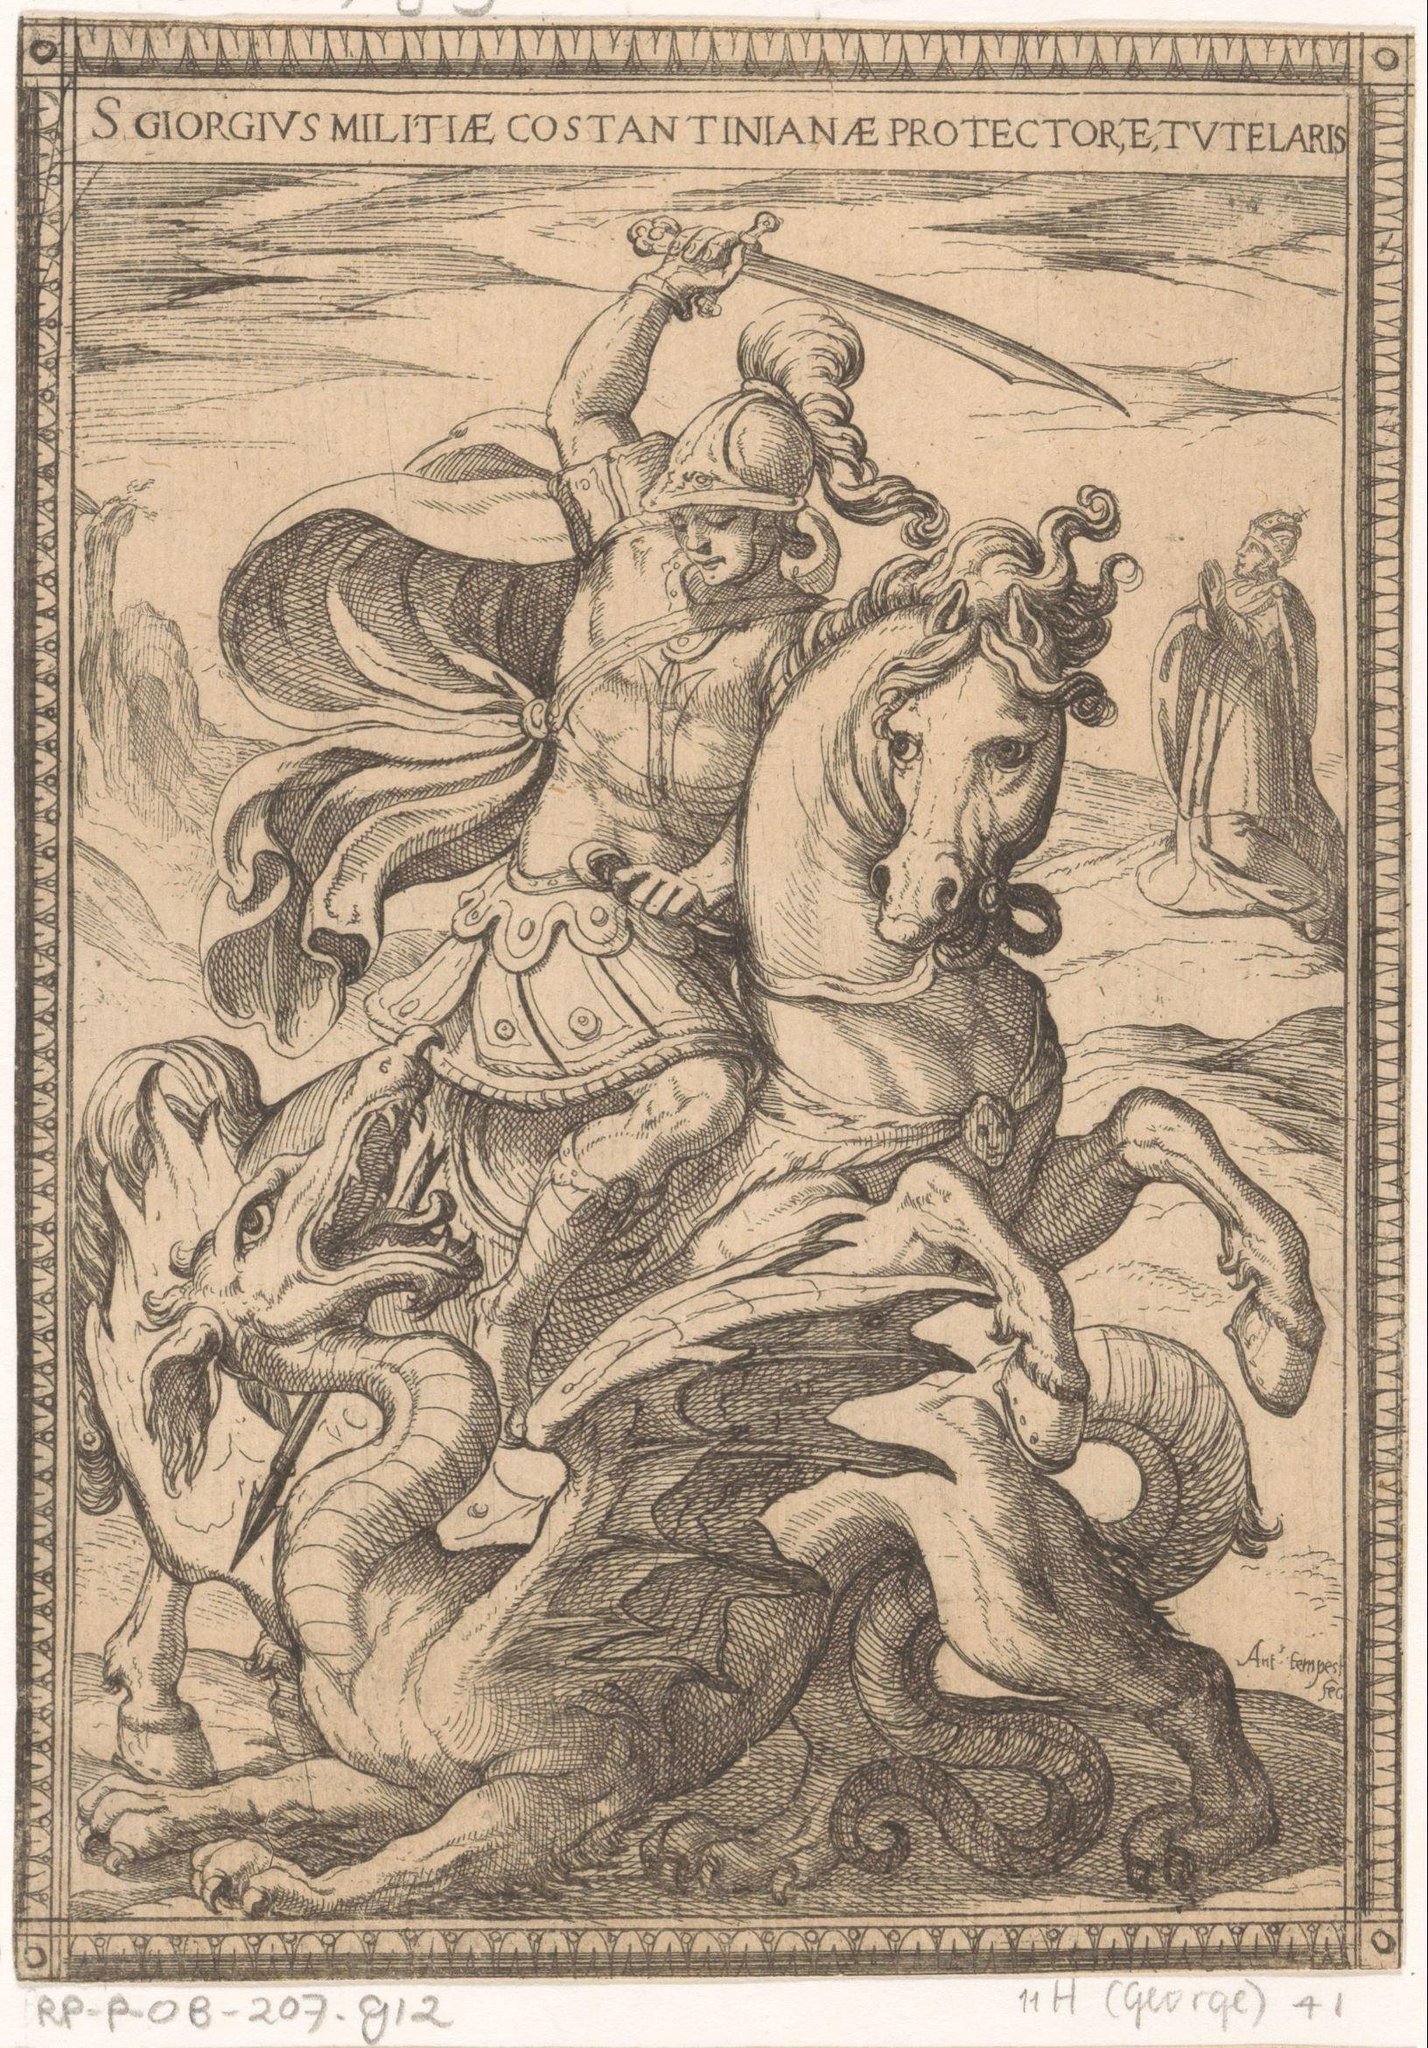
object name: print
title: Saint George Killing the Dragon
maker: antonio tempesta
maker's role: draughtsman, painter, print maker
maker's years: 1555-1630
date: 1565-1630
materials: paper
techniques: etching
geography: italy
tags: emperor, dragon, the warrior martyr george (georgius); possible attributes: banner (red cross on white field), (red) cross, dragon, (white) horse, broken lance, shield (with cross), sword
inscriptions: collector's mark: Lugt 240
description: De heilige Joris zit met opgeheven zwaard op een steigerend paard. Op de voorgrond een draak met afgebroken pijl door zijn kop. Op de achtergrond knielt keizer Constantijn de Grote